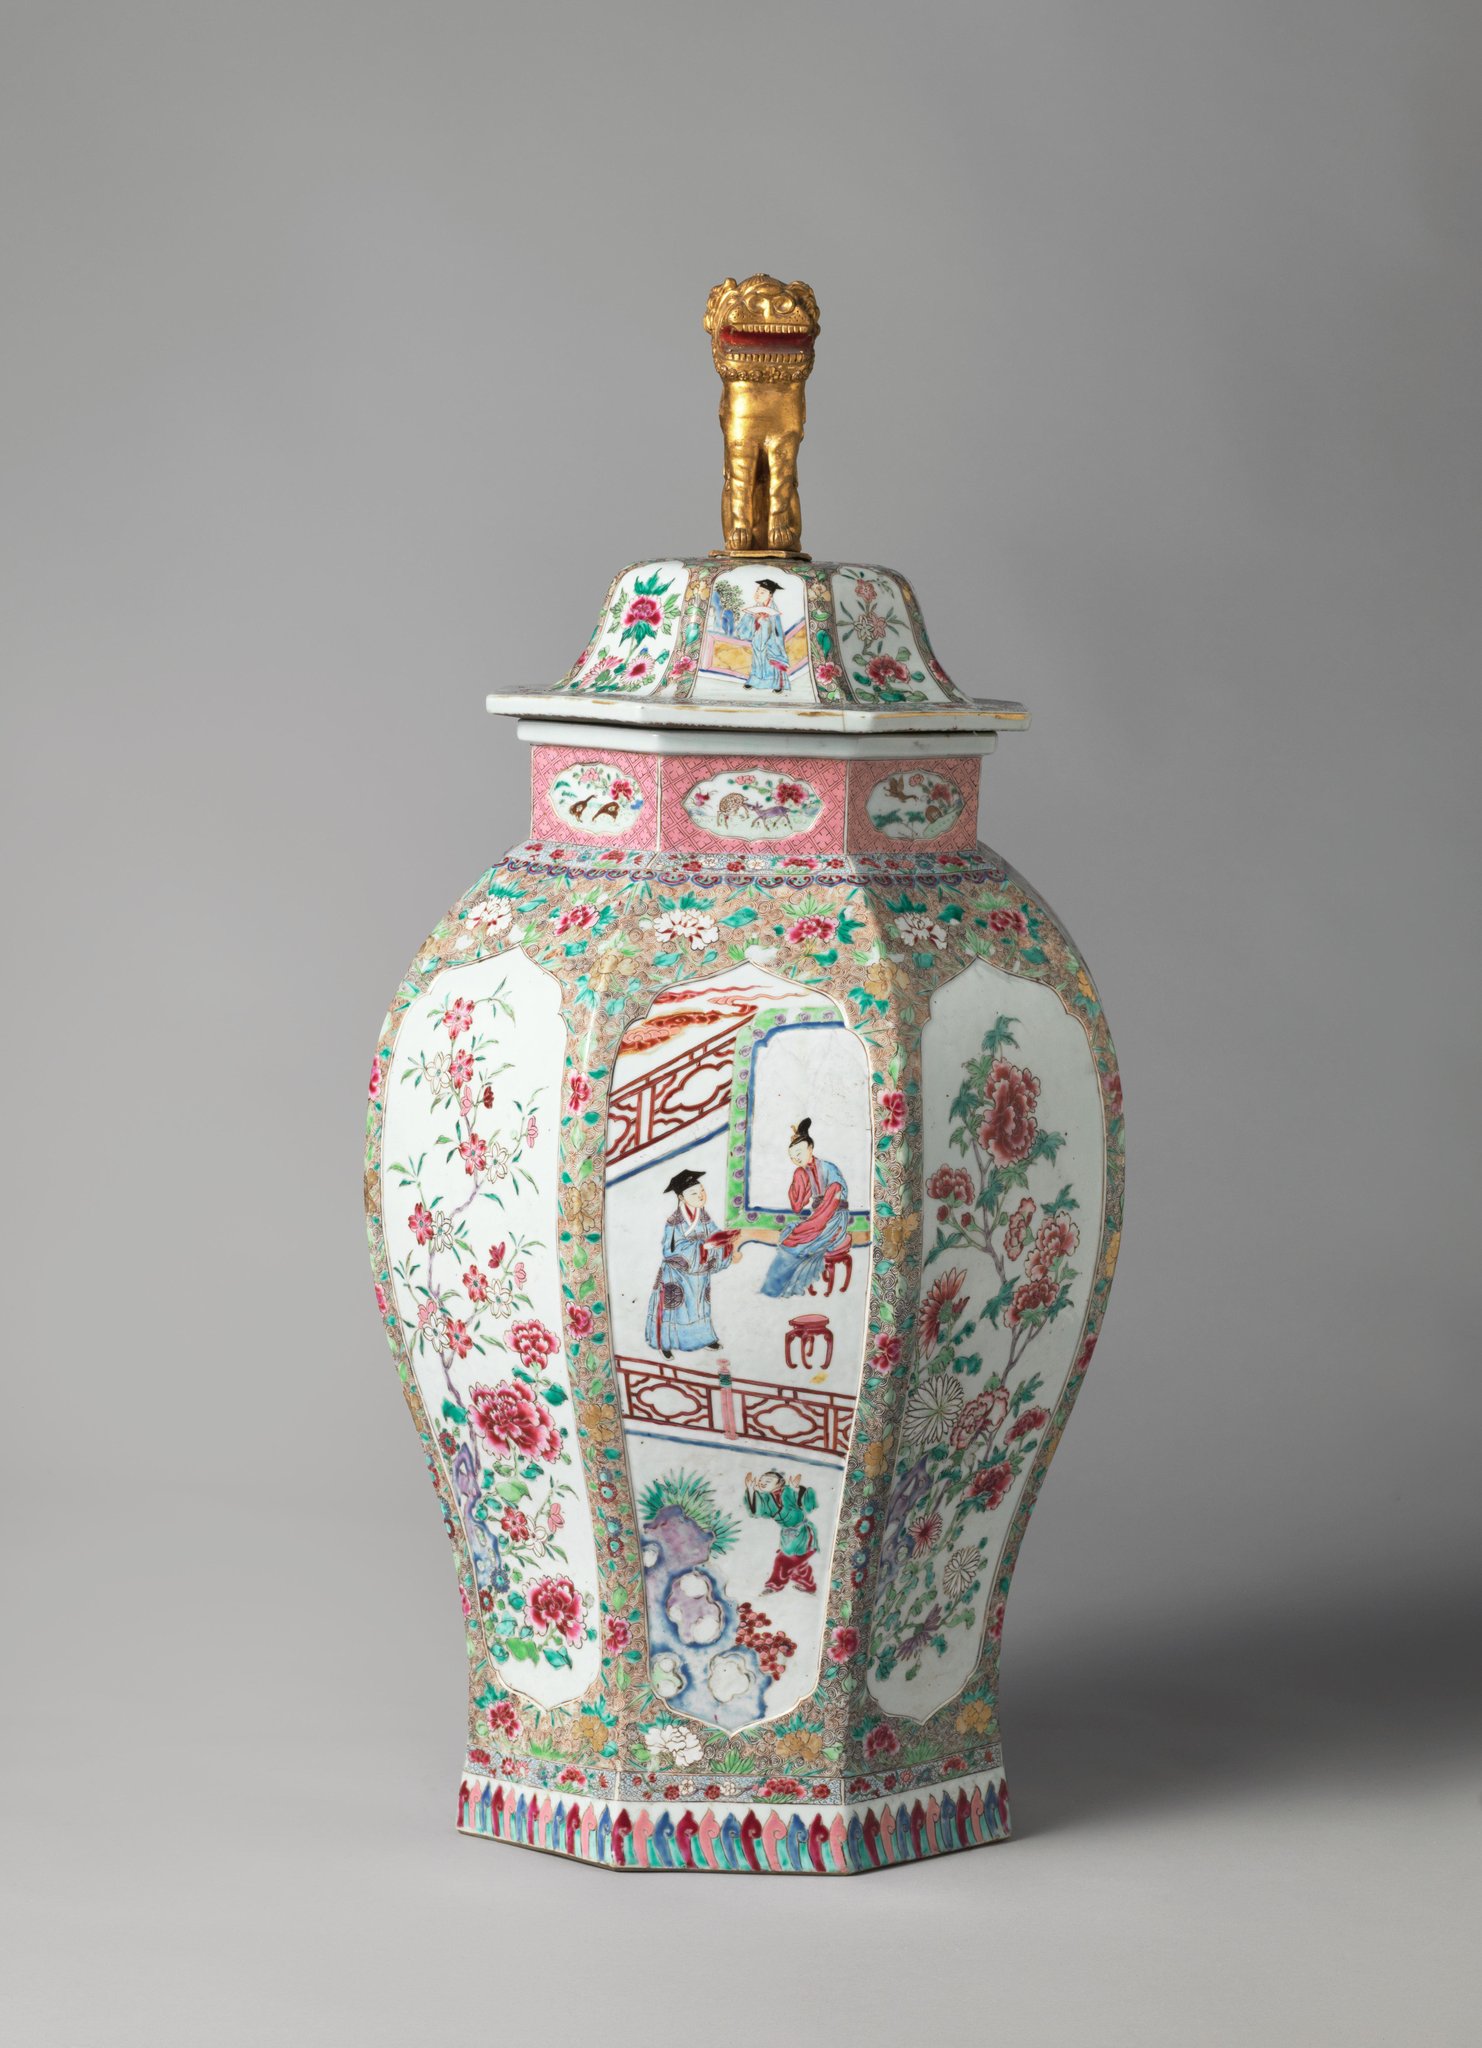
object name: lid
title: Octagonal cover with flowering plants and figures in a fenced garden in panels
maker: Anonymous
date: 1800-1899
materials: glaze, gold, paint, porcelain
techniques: firing, forming, gilding, turning, vitrification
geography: china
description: Achthoekige deksel van porselein, beschilderd op het glazuur in blauw, rood, roze, groen, paars, zwart en goud. Bedekt met pioentakken tegen een achtergrond van een spiraal-patroon. Op elk van de acht zijden een uitgespaard, geschulpt cartouche met afwisselend bloemtakken (pioen, chrysant, aster, prunus) bij een rots of één of meerdere personen op een terras of in een omheinde tuin bij bloeiende planten en rotsen. De rand met acht vakken met bloeiende planten tegen een achtergrond van blauw kikkerdril. Dekselknop is in de vorm van een shishi (leeuwhond). Dekselknop is niet origineel. Deksel is onderdeel van kaststel AK-NM-11497. Famille rose.